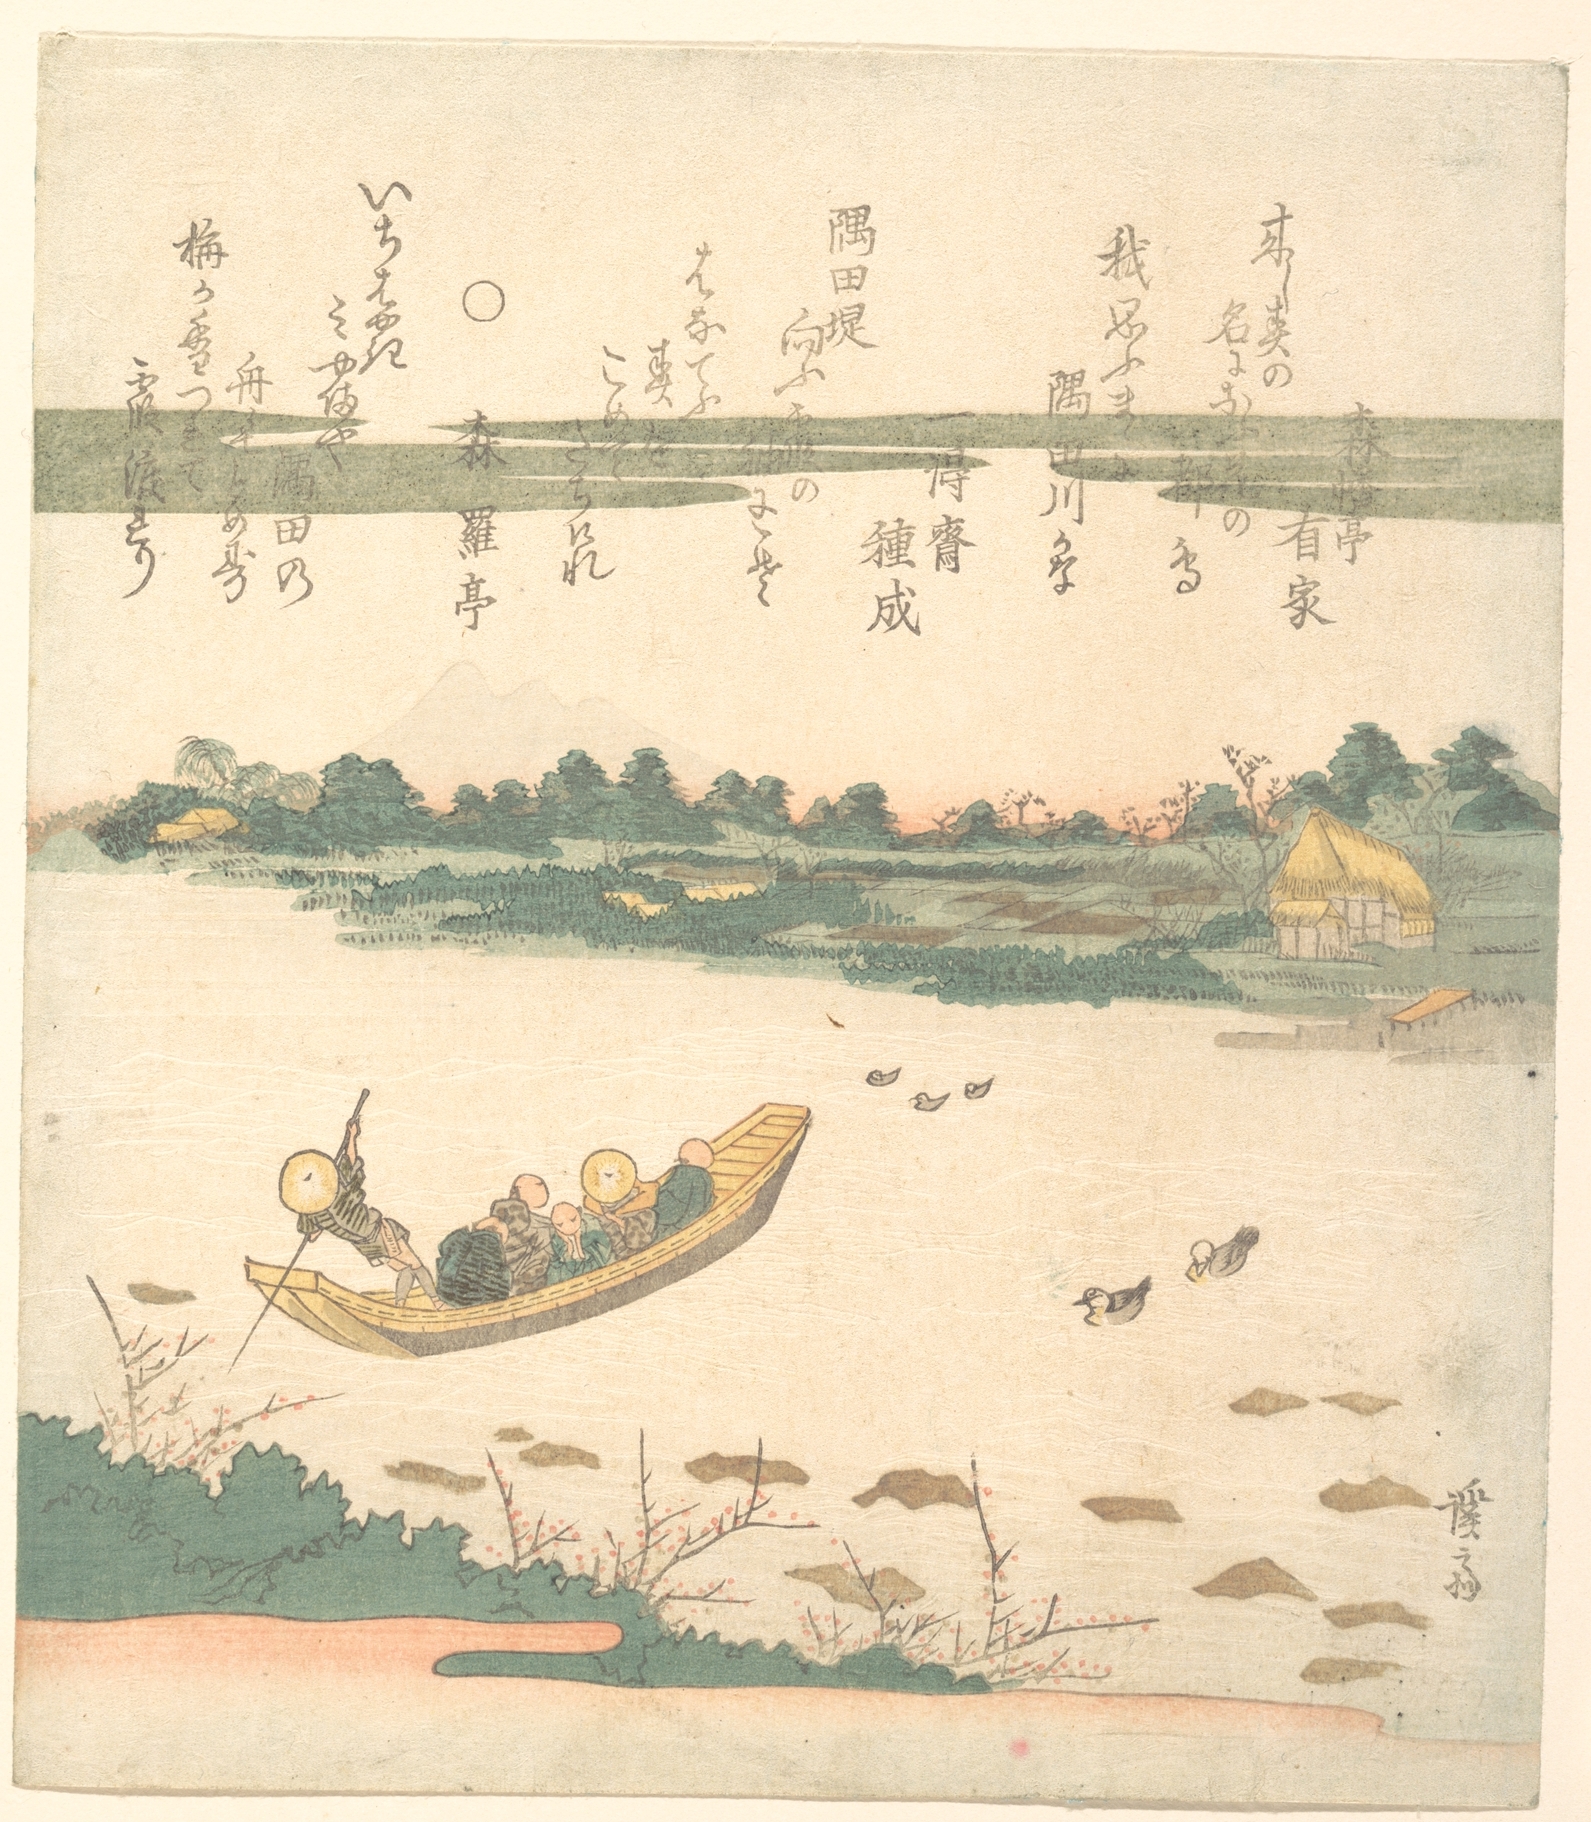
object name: print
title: Ferry Boat Crossing the Sumida River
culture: japanese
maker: keisai eisen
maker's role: artist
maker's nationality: japanese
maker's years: 1790-1848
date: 1840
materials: ink, paper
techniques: surimono, woodblock print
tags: human figures,animals,rivers,boats